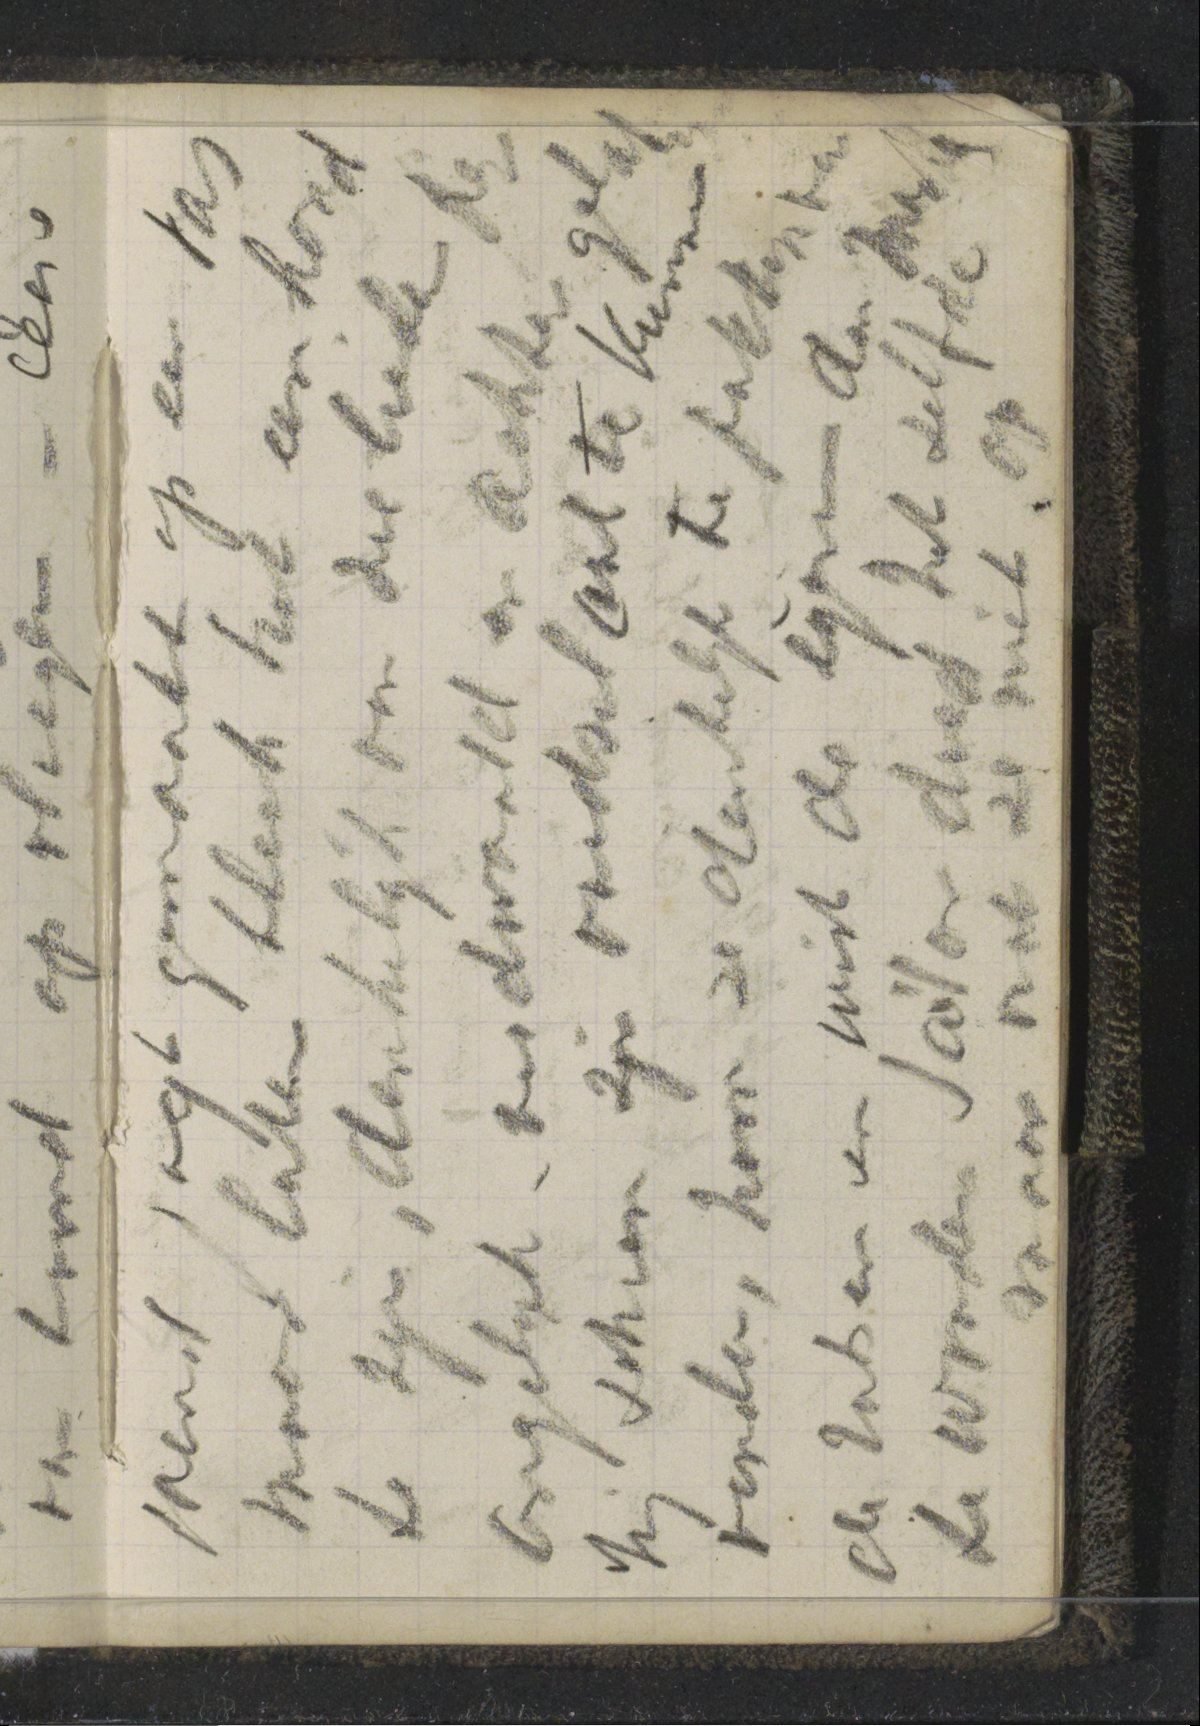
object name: sketchbook leaf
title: Reisverslag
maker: louis apol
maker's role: draughtsman, painter, print maker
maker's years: 1850-1936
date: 1809-1880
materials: pencil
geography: netherlands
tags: nova zembla expedities 1880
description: Blad 104 recto uit een schetsboek met 110 bladen betekend tijdens de expeditie naar Nova Zembla in 1880.